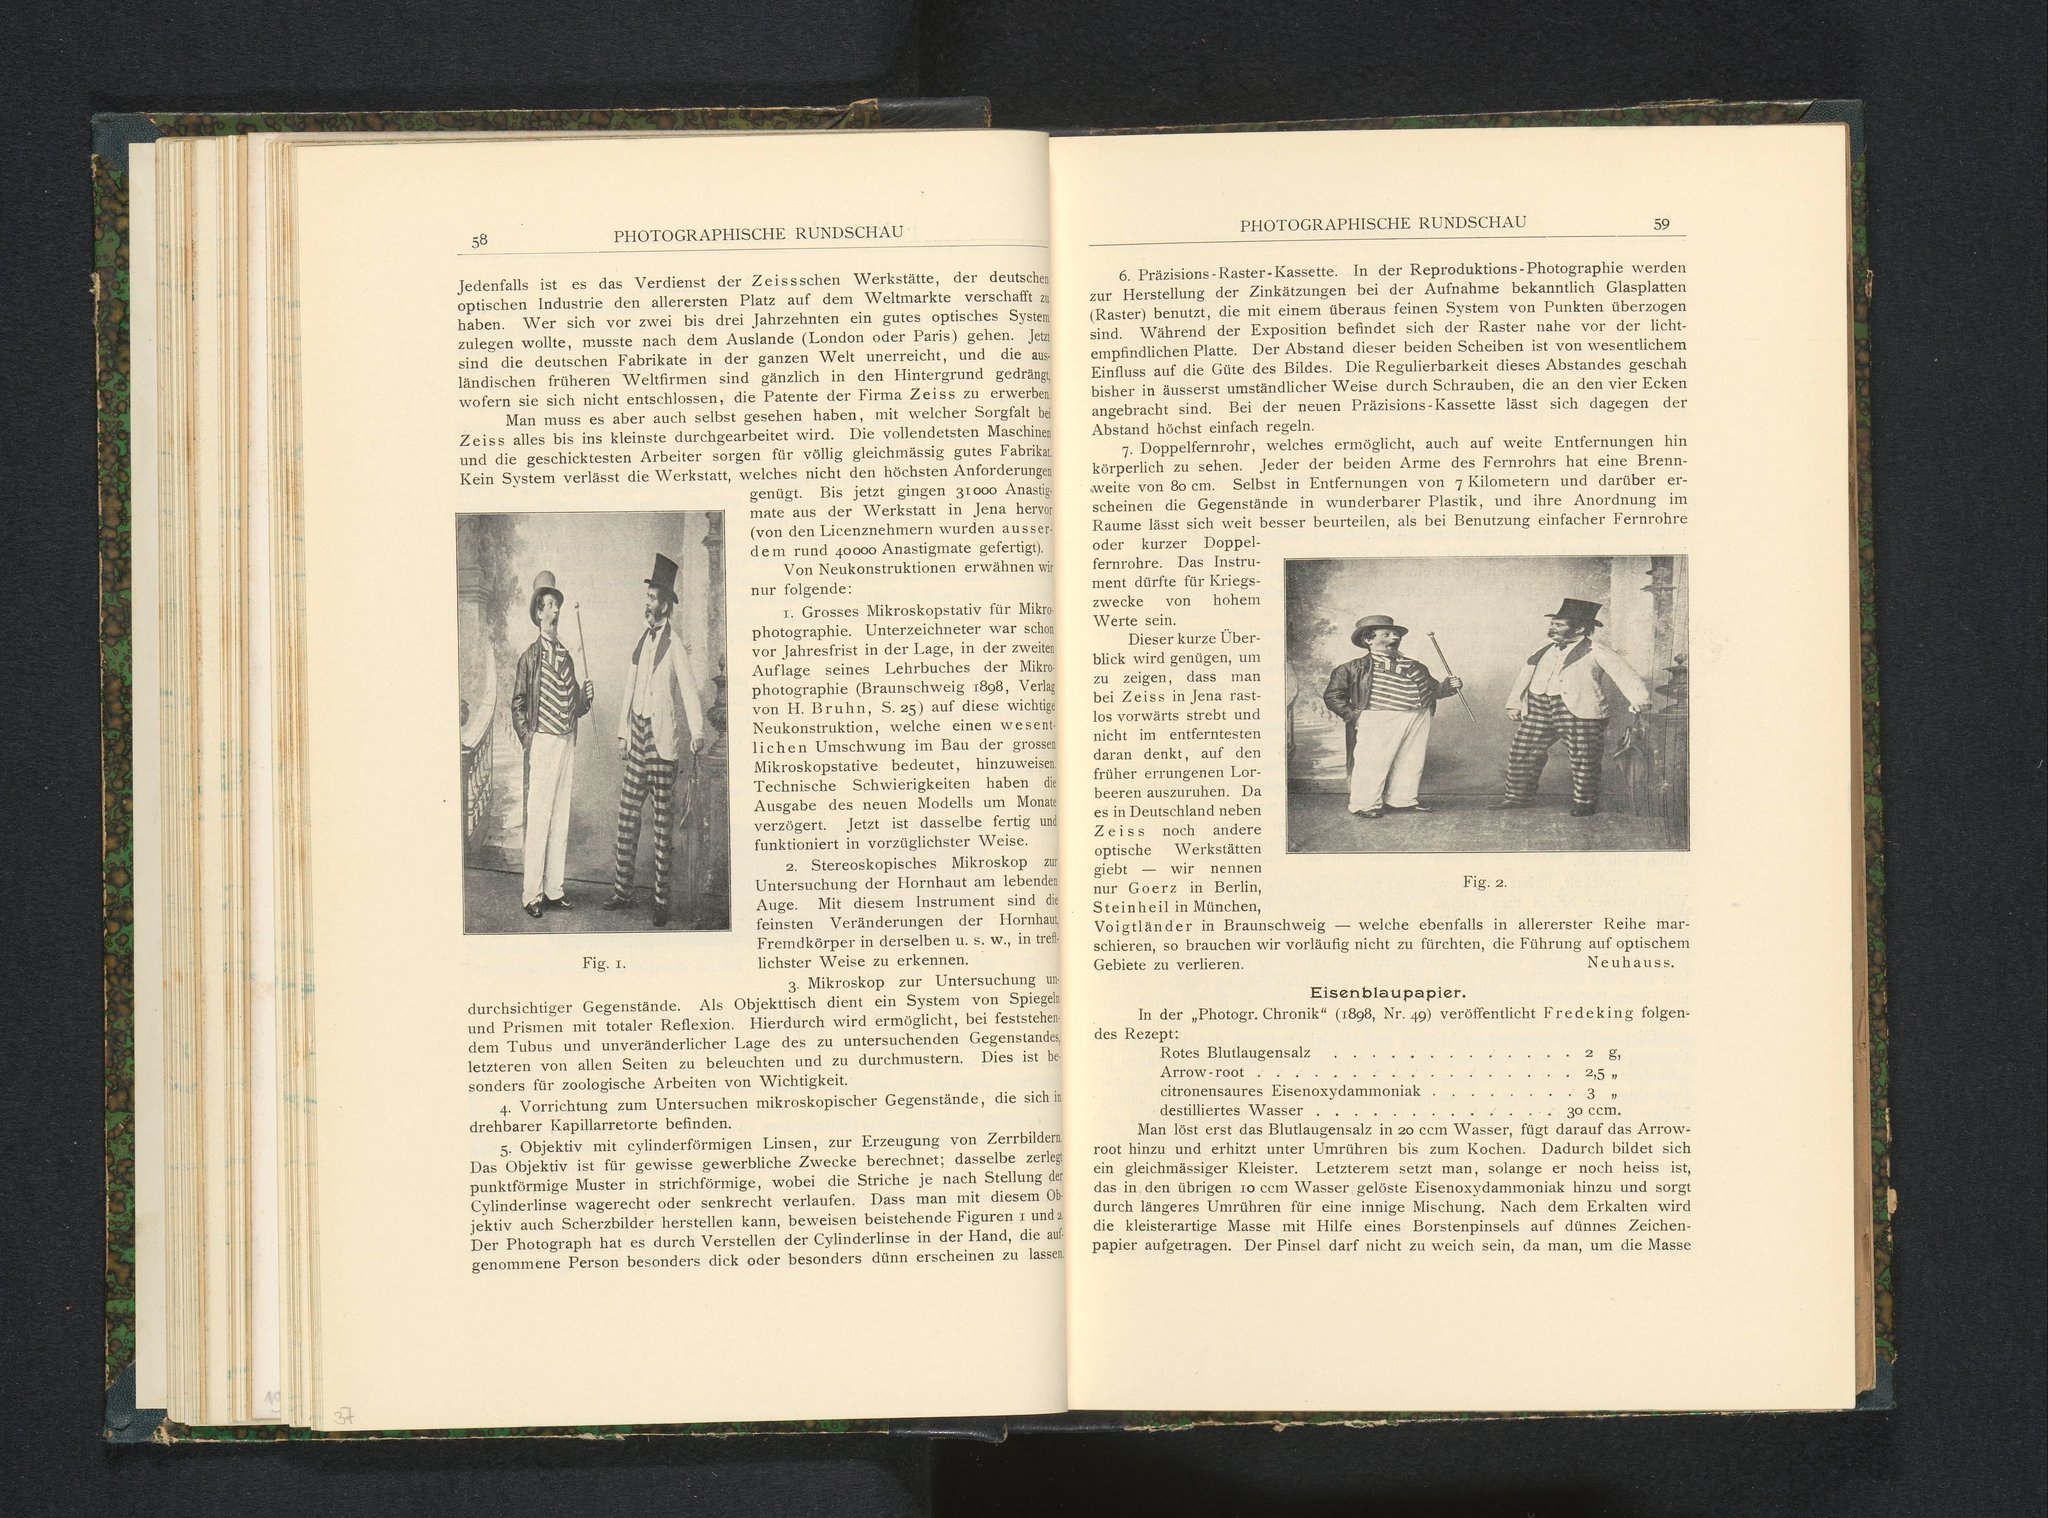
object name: page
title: Portret van twee onbekende mannen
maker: Anonymous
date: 1894-1899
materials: paper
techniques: autotype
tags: head-gear: hat, anonymous historical person portrayed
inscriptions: inscription: ‘Fig. 1’